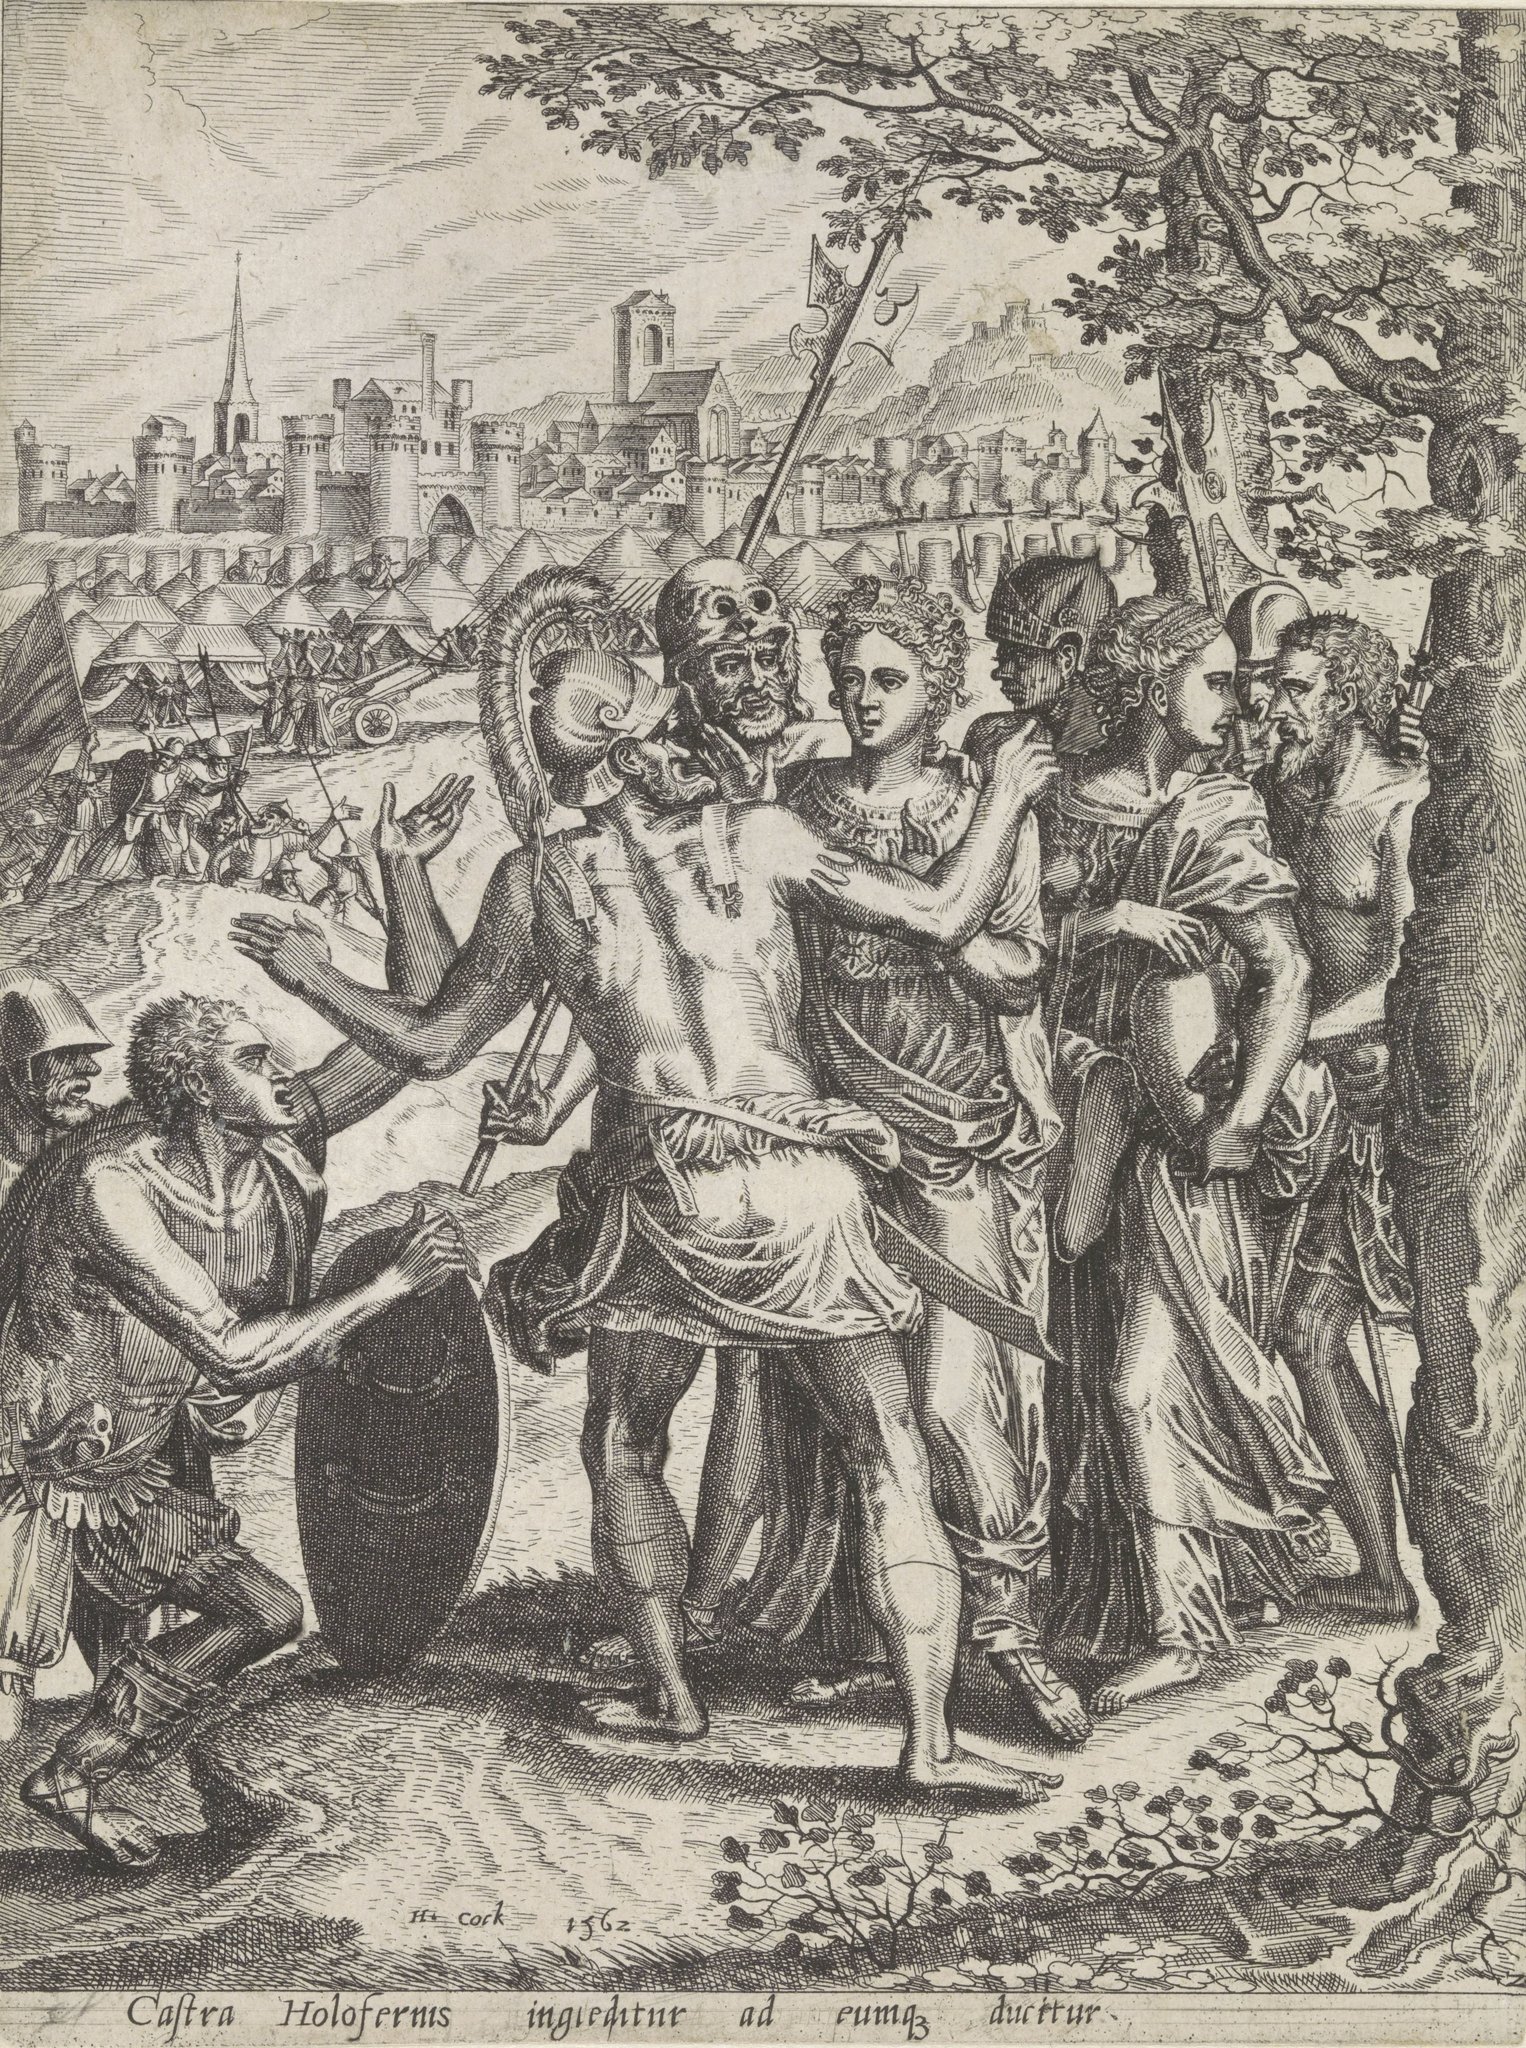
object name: print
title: Judith en haar dienstmaagd onderweg naar het kamp van Holofernes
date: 1562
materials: paper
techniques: etching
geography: antwerp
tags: 71u423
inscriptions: collector's mark:, collector's mark: Lugt 2760, collector's mark: Lugt 2228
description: Judith met haar dienstmaagd onderweg naar het kamp van Holofernes worden staande gehouden door de wachters van de Assyriërs. Plaat nr. 2 in een serie van vier over het verhaal van Judith en Holofernes.